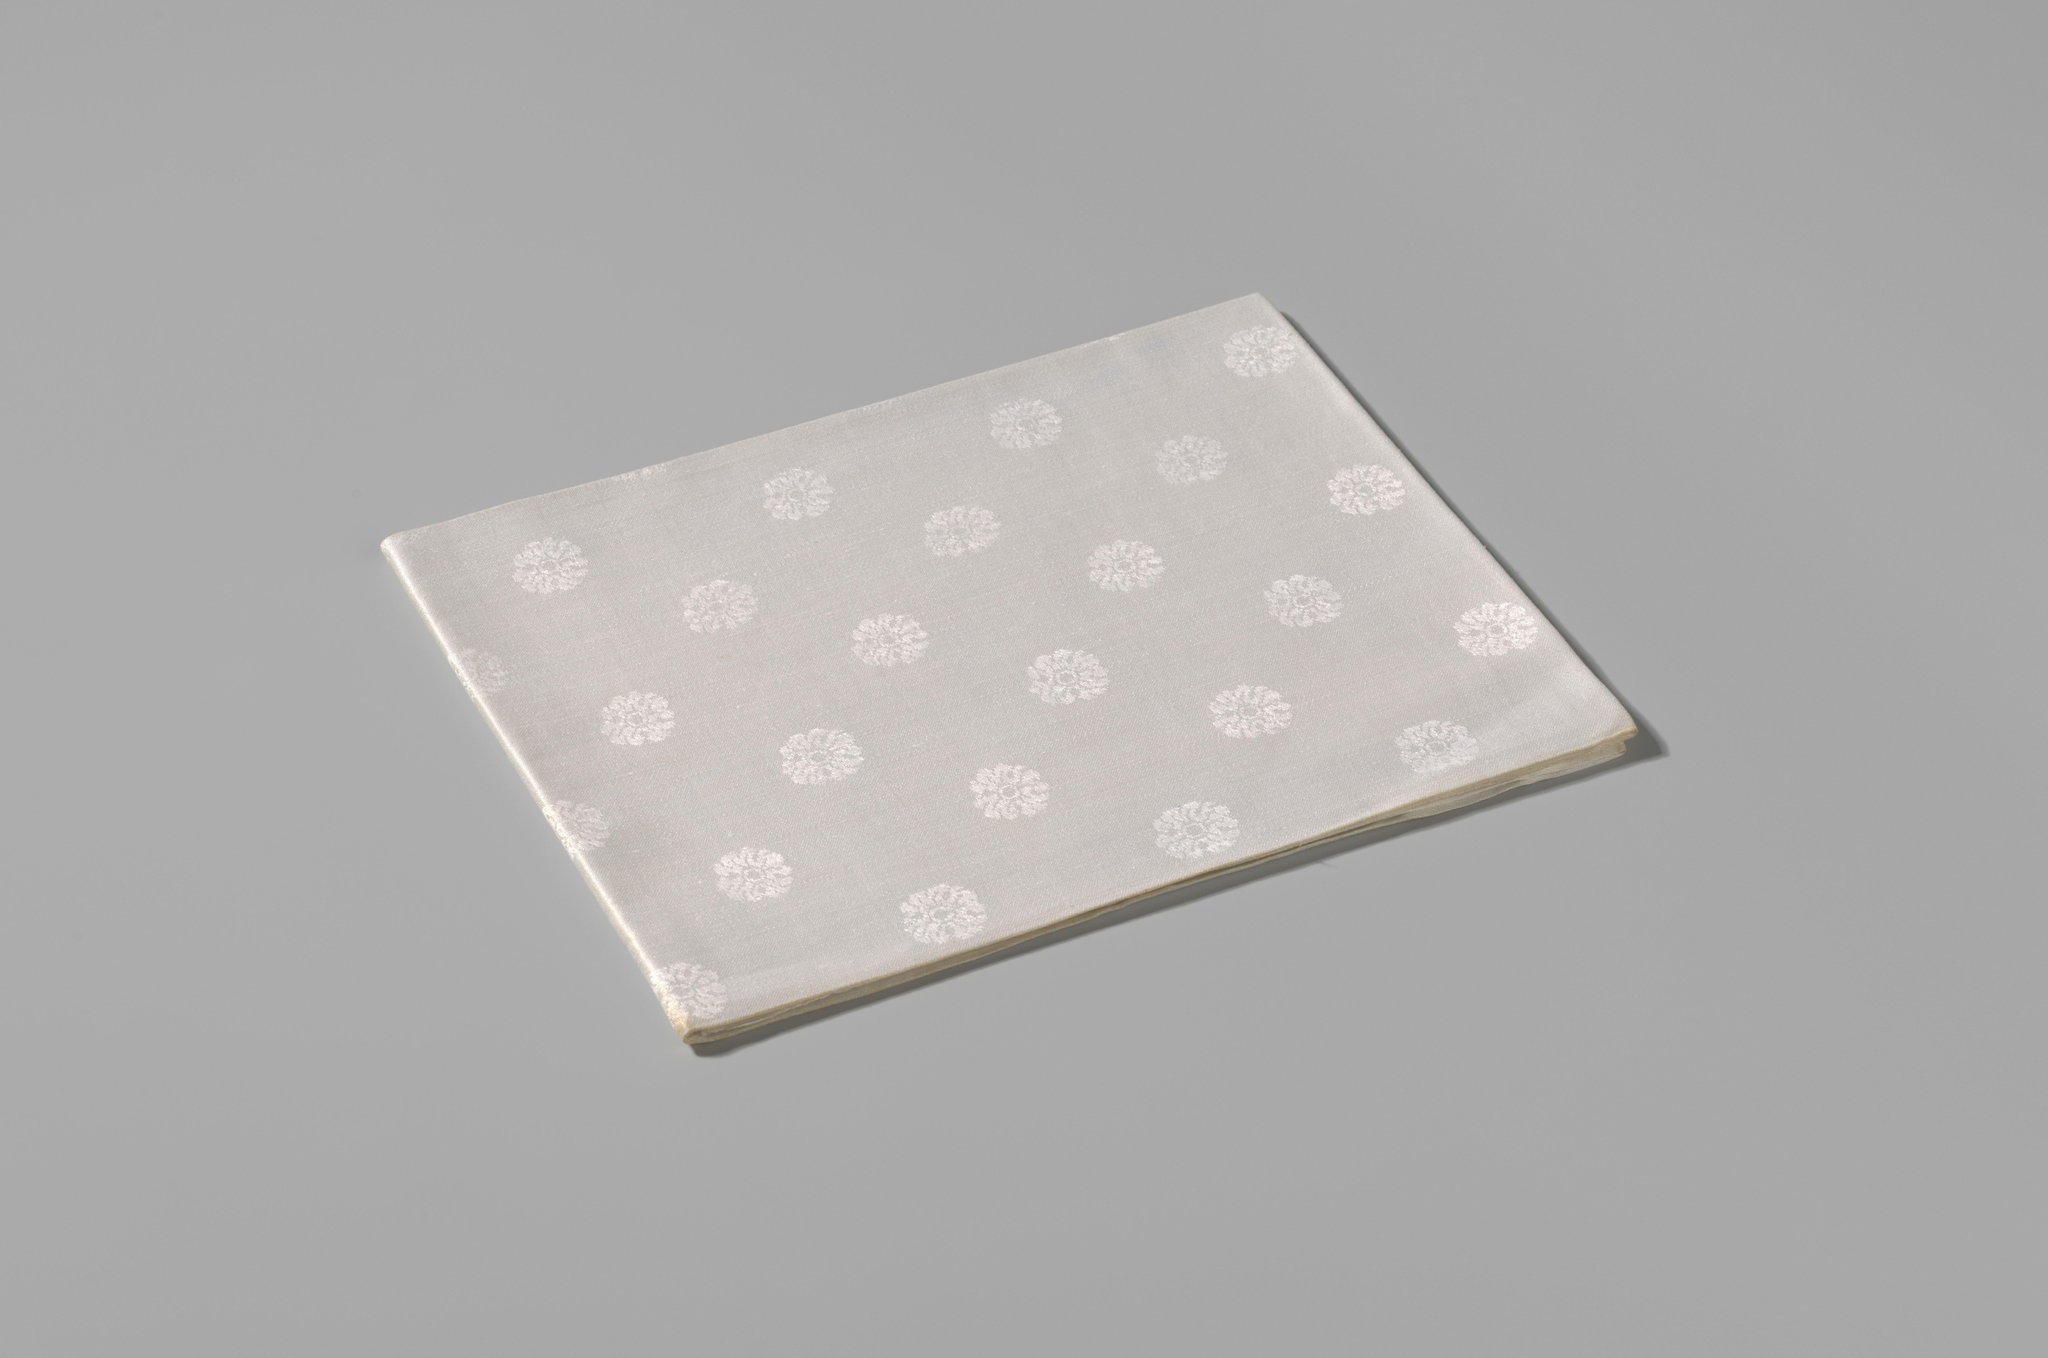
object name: napkin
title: Servet met patroon van rozetten en rozentakken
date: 1780-1800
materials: linen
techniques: damask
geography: northern netherlands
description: Wit linnendamasten servet met een patroon van rozetten en rozentakken, merk 100 en HW 30.